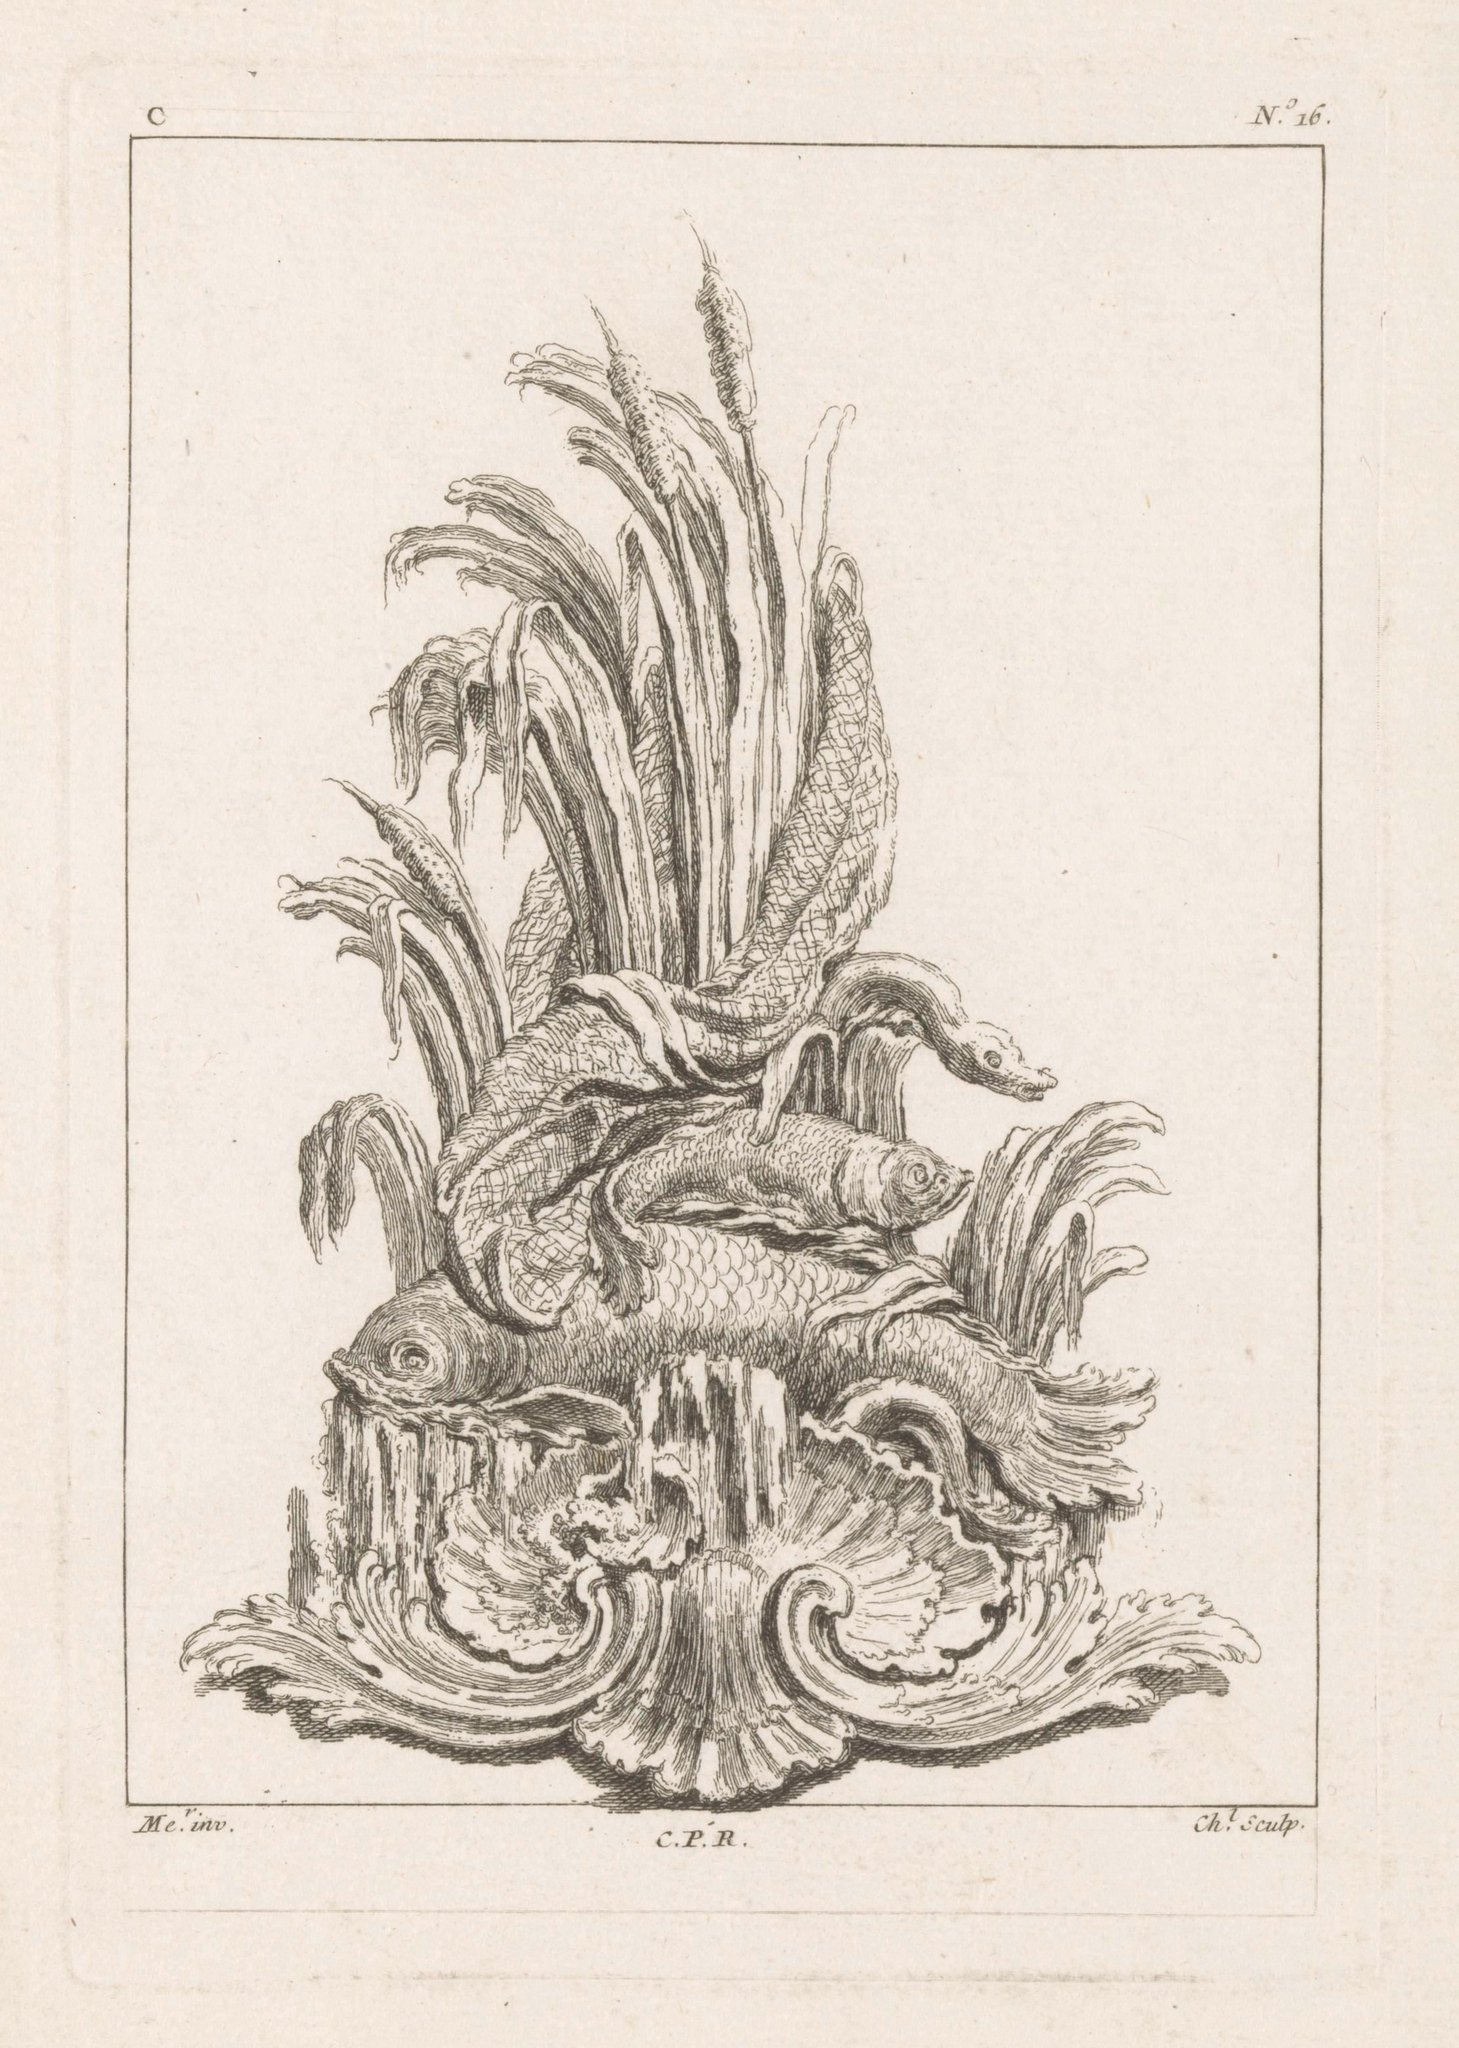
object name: print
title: Oeuvre de Juste Aurele Meissonnier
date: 1738-1749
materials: paper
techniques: etching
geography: paris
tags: fishes, scallop, shell ~ ornament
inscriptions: collector's mark: Lugt 2228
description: Een schelpmotief met vissen, een visnet en lisdodden. Prentnummer 16.